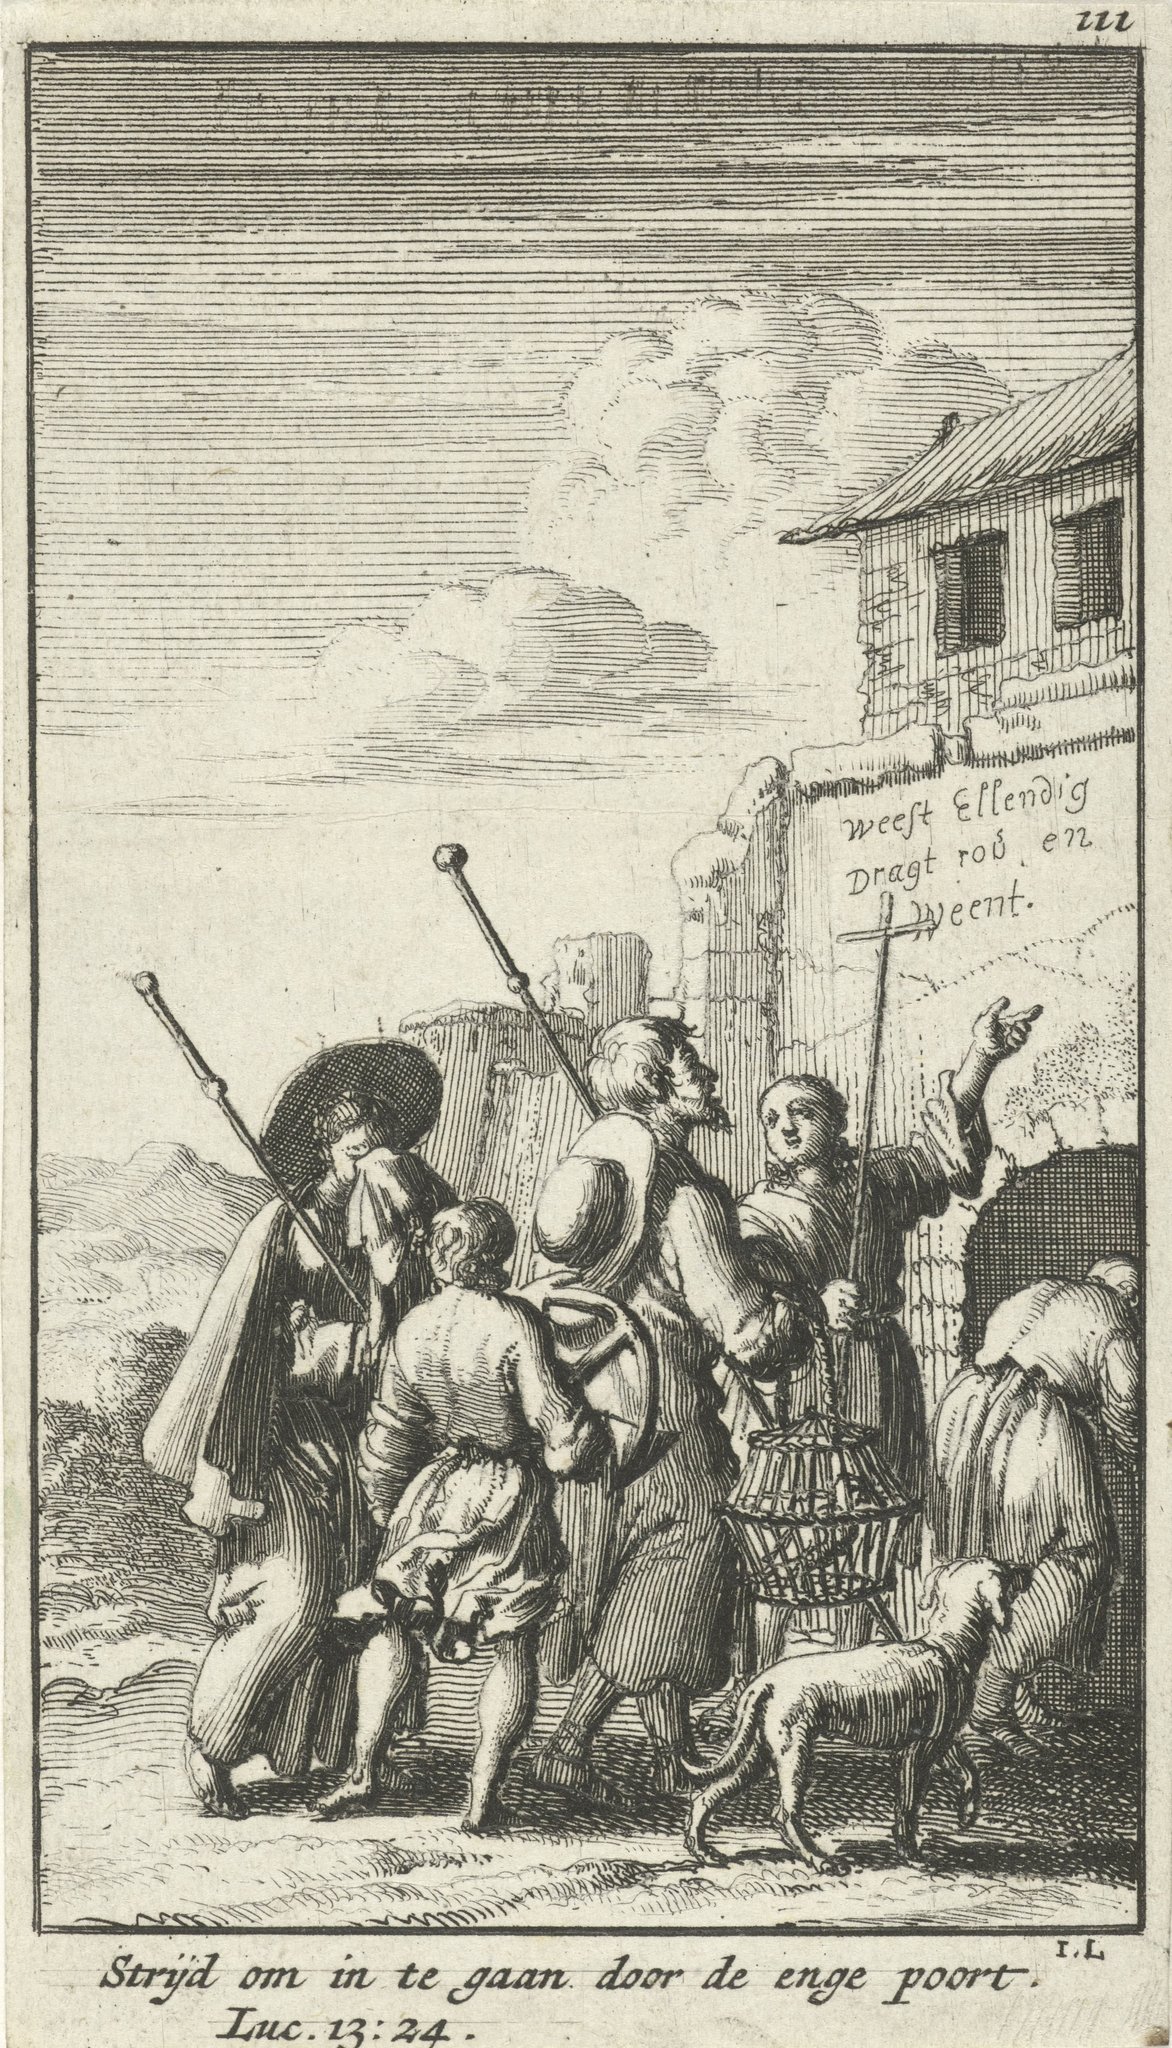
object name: print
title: Vijf pelgrims voor een poort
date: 1683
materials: paper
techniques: etching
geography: amsterdam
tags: pilgrimage, pilgrim(s) under way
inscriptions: collector's mark: Lugt 240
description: Illustratie opgenomen in: Dircksz, Jacob (Oom). Een alegoris-historis verhaal van het edel en machtig koninkrĳk van Salem. Amsterdam: Jan Rieuwertsz (I), 1683.